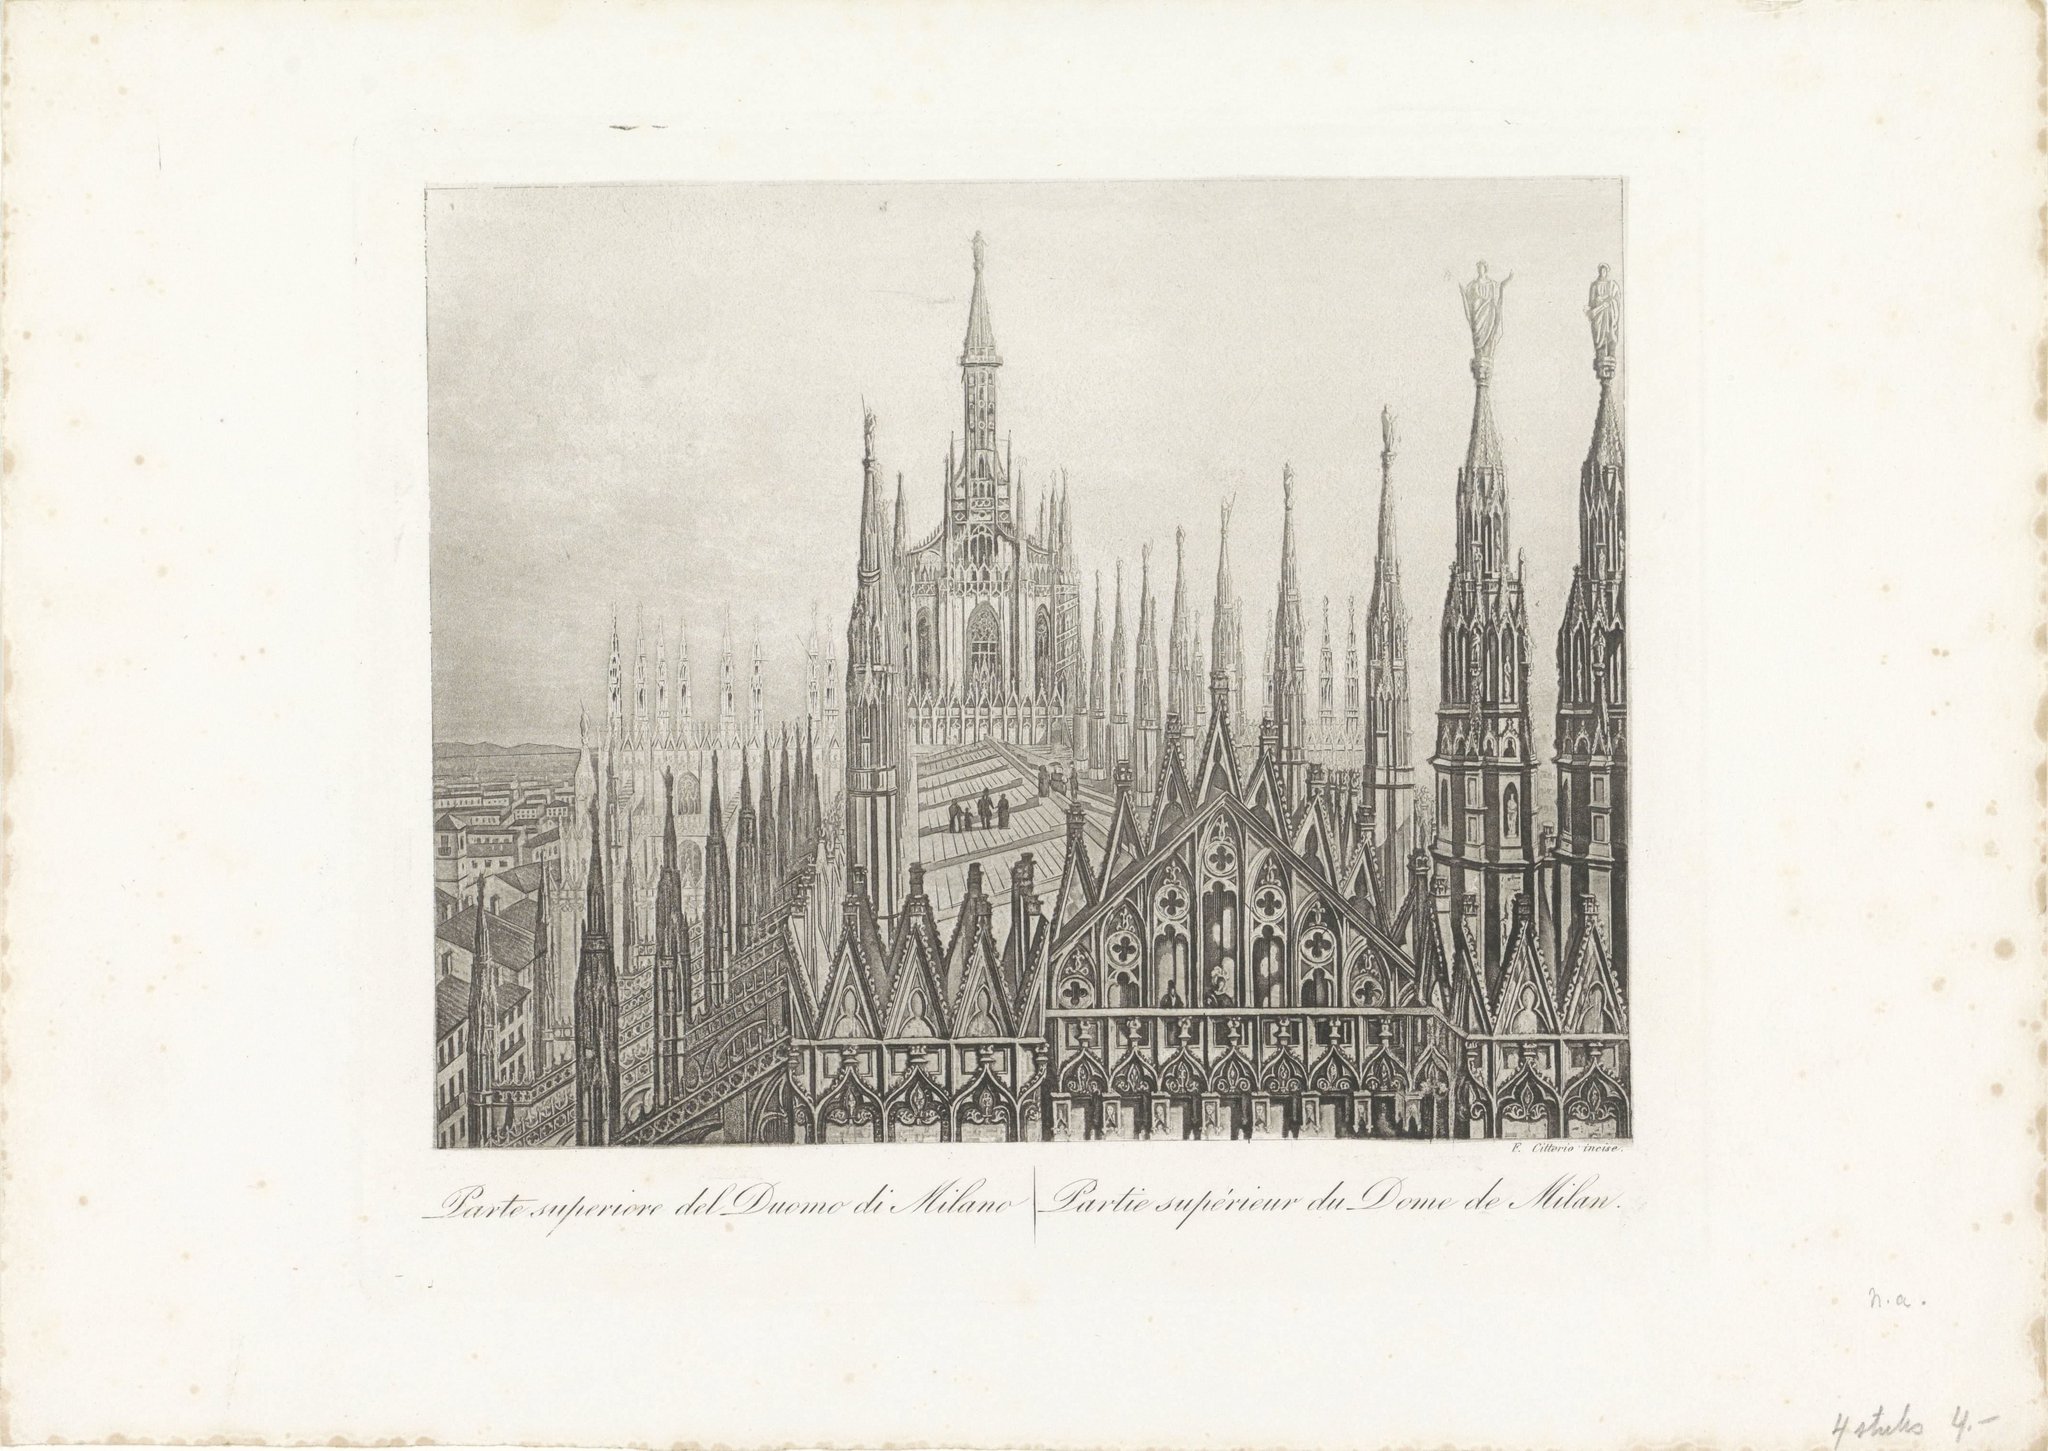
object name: print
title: Dak van de Dom van Milaan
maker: francesco citterio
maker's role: print maker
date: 1800-1899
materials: paper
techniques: aquatint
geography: italy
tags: church (exterior), parts of church exterior and annexes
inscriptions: collector's mark: Lugt 2228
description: Gezicht op het dak van de Dom van Milaan, vanaf de façade richting de achterzijde van de kerk.